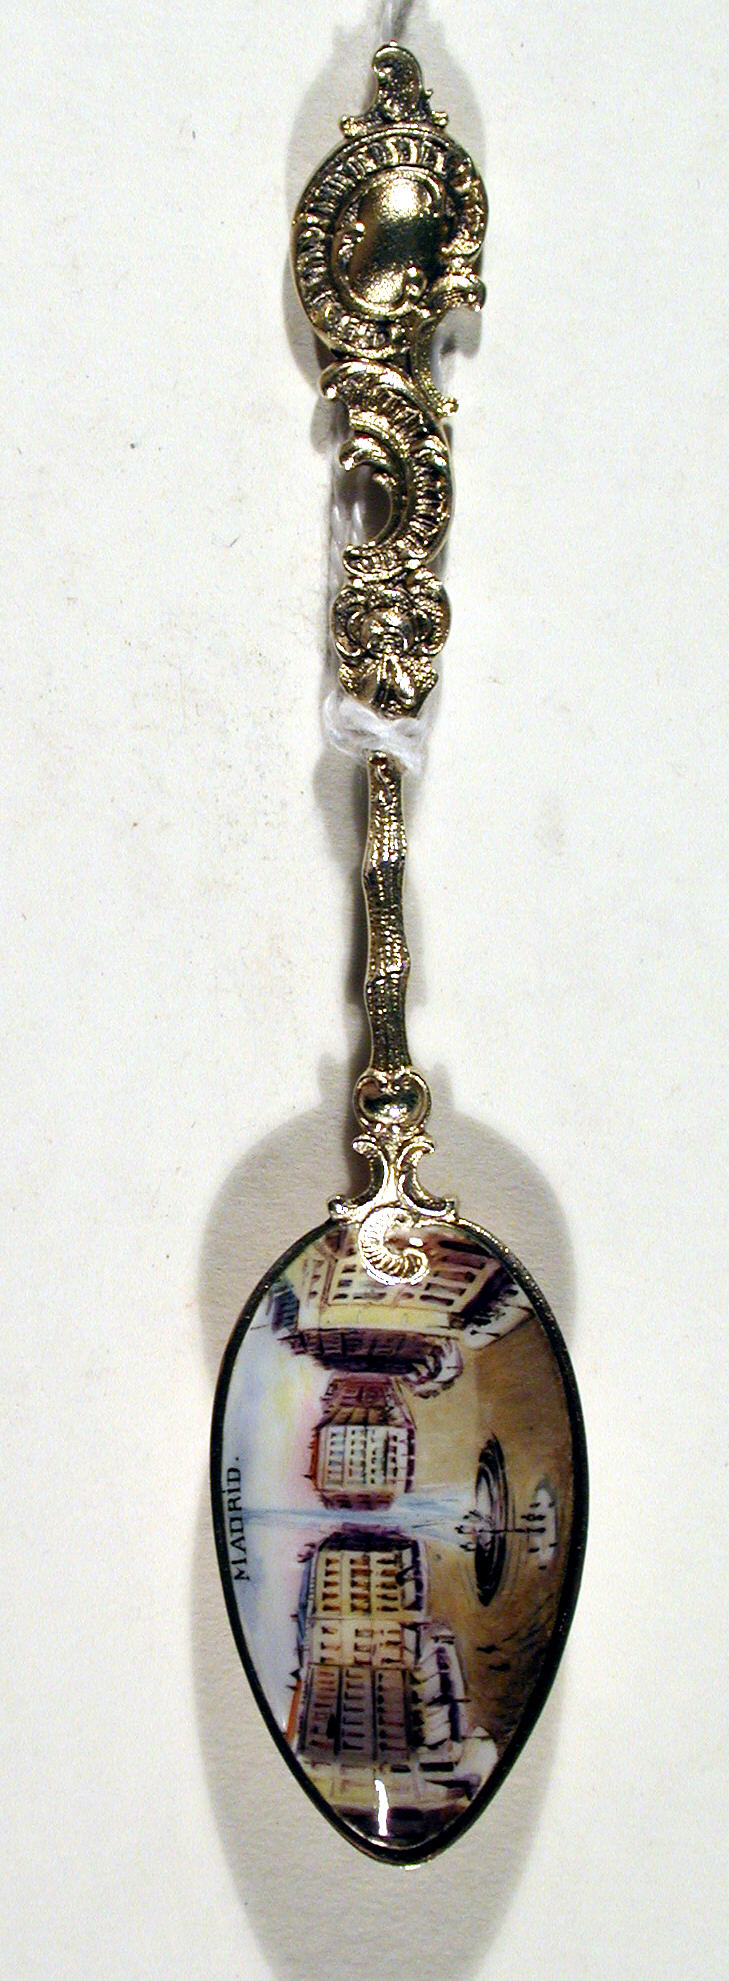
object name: souvenir spoon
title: Souvenir spoon with view of plaza and fountain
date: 1867-1900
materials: enamel, silver gilt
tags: buildings,fountains